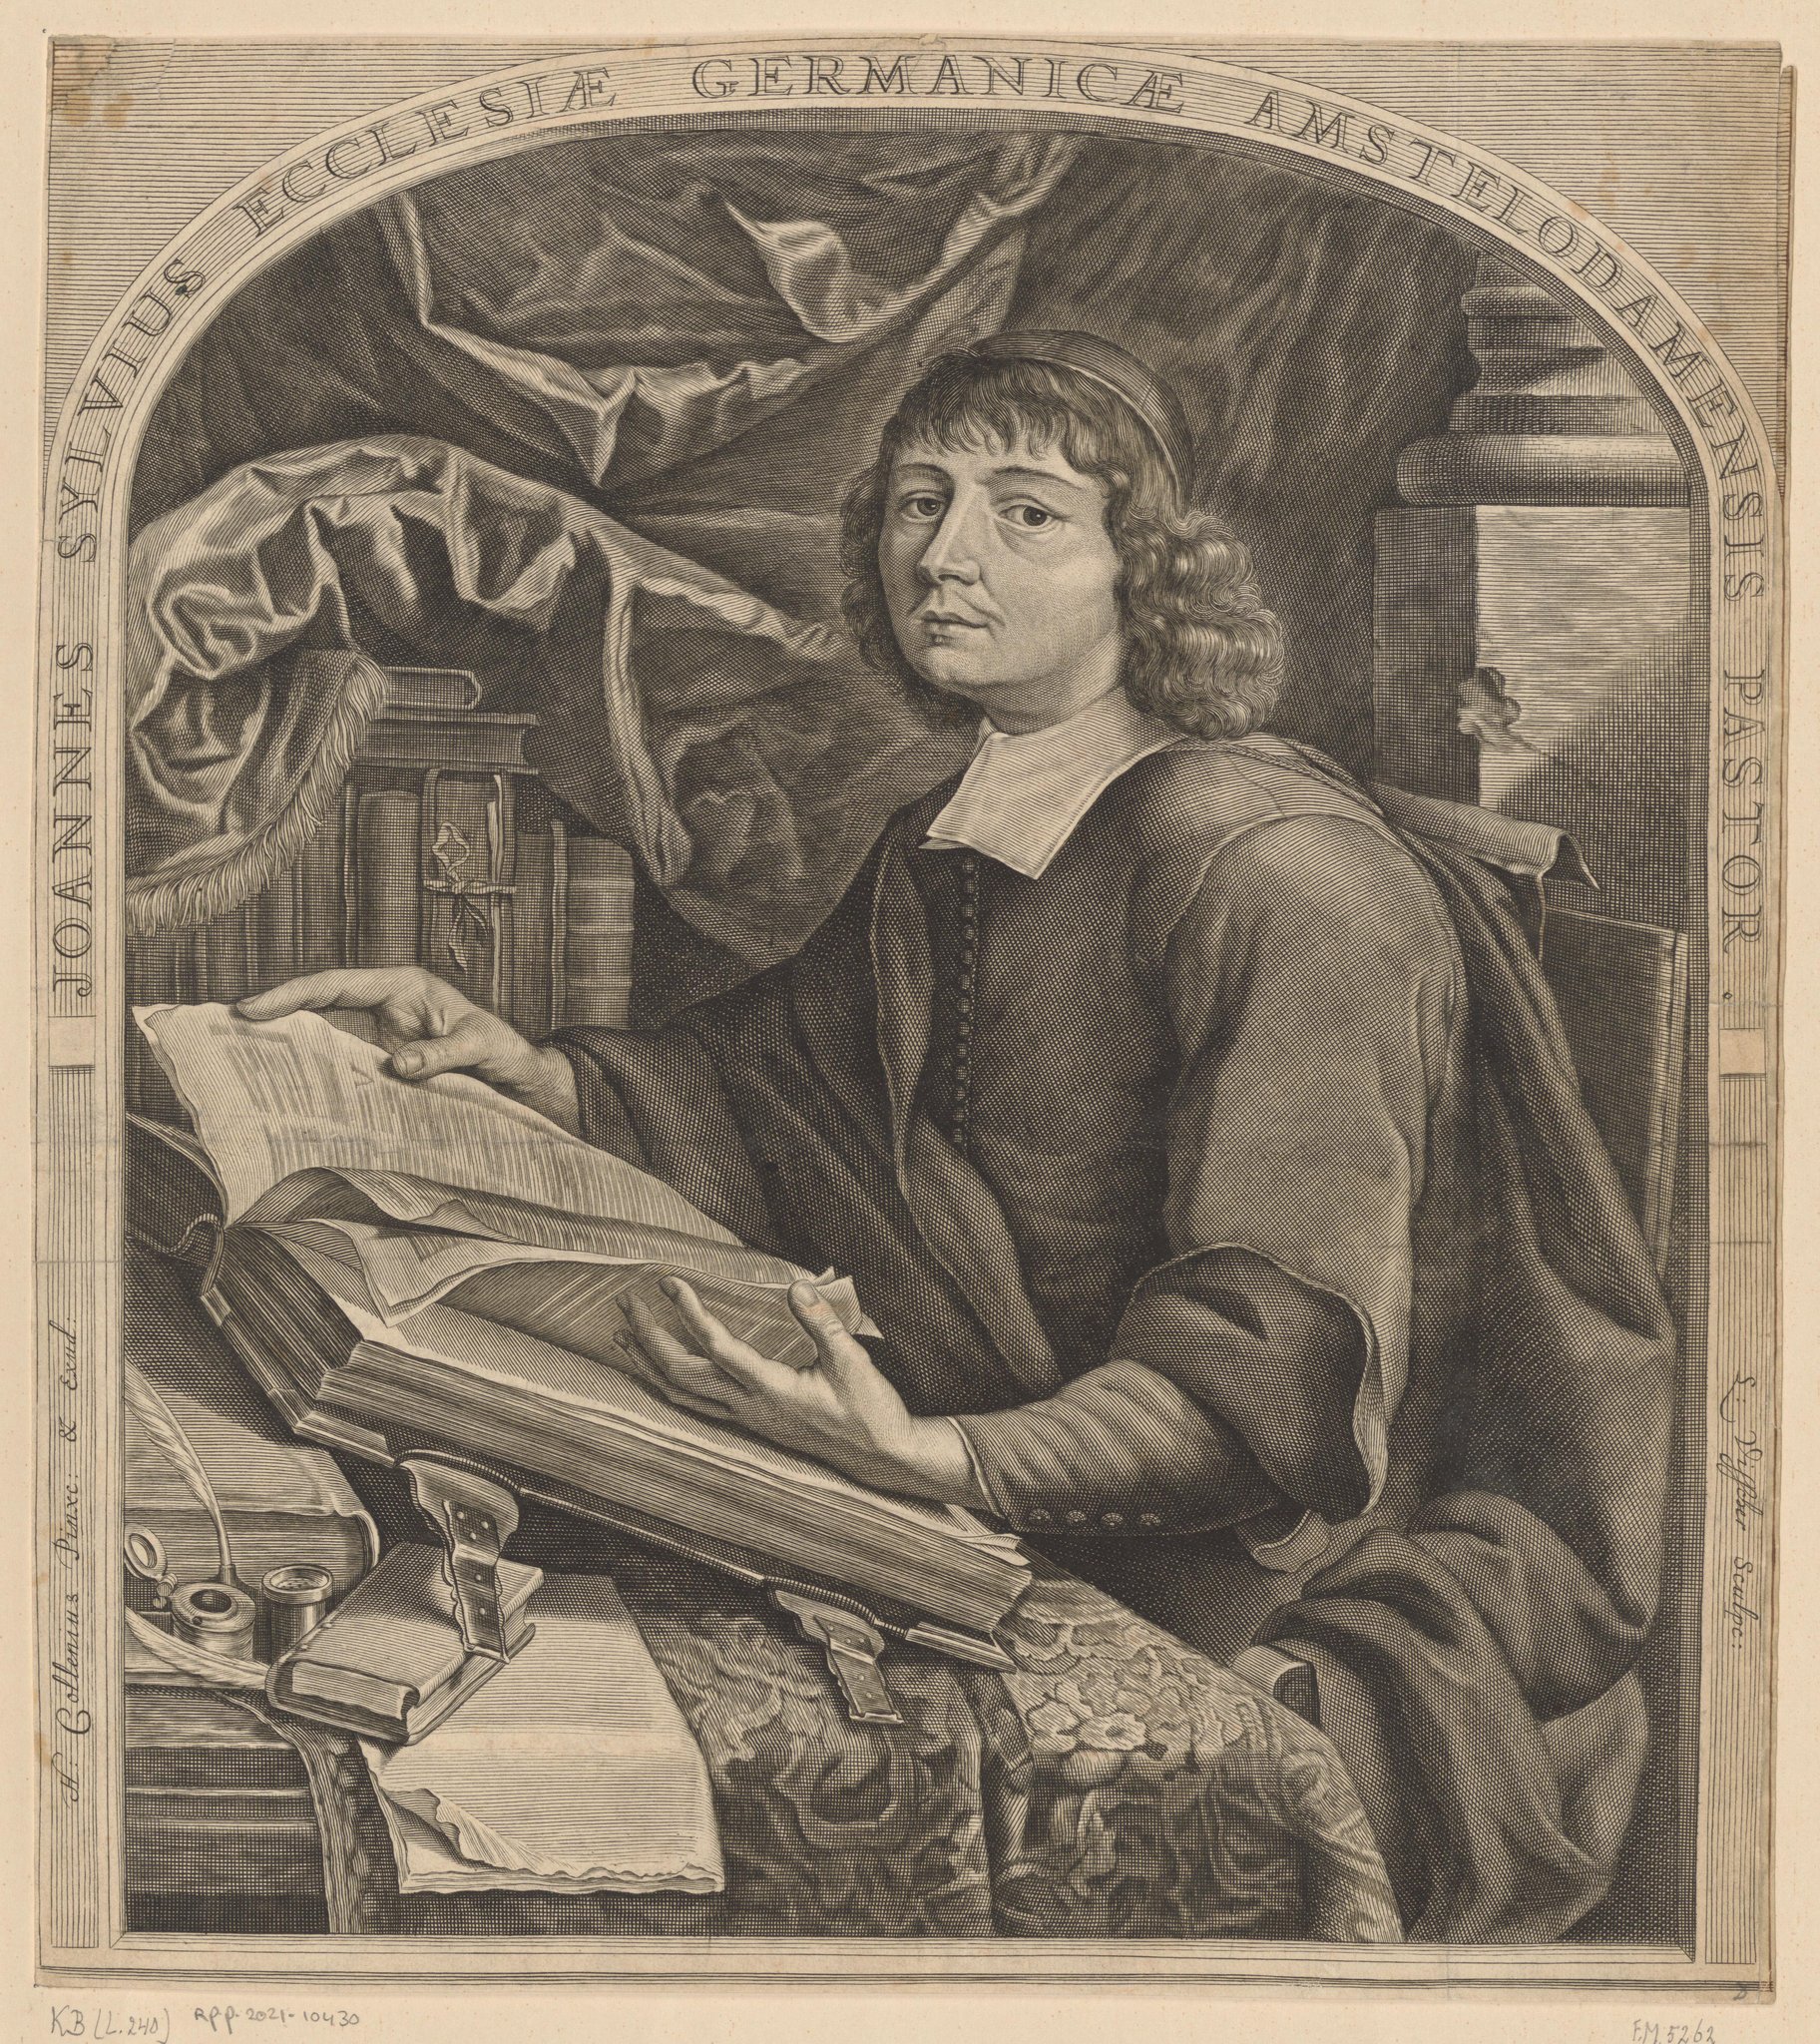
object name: print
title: Portret van Johannes Sylvius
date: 1643-1690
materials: paper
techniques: engraving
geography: amsterdam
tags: amsterdam, adult man, historical persons, book - mm - book open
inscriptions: collector's mark: Lugt 240